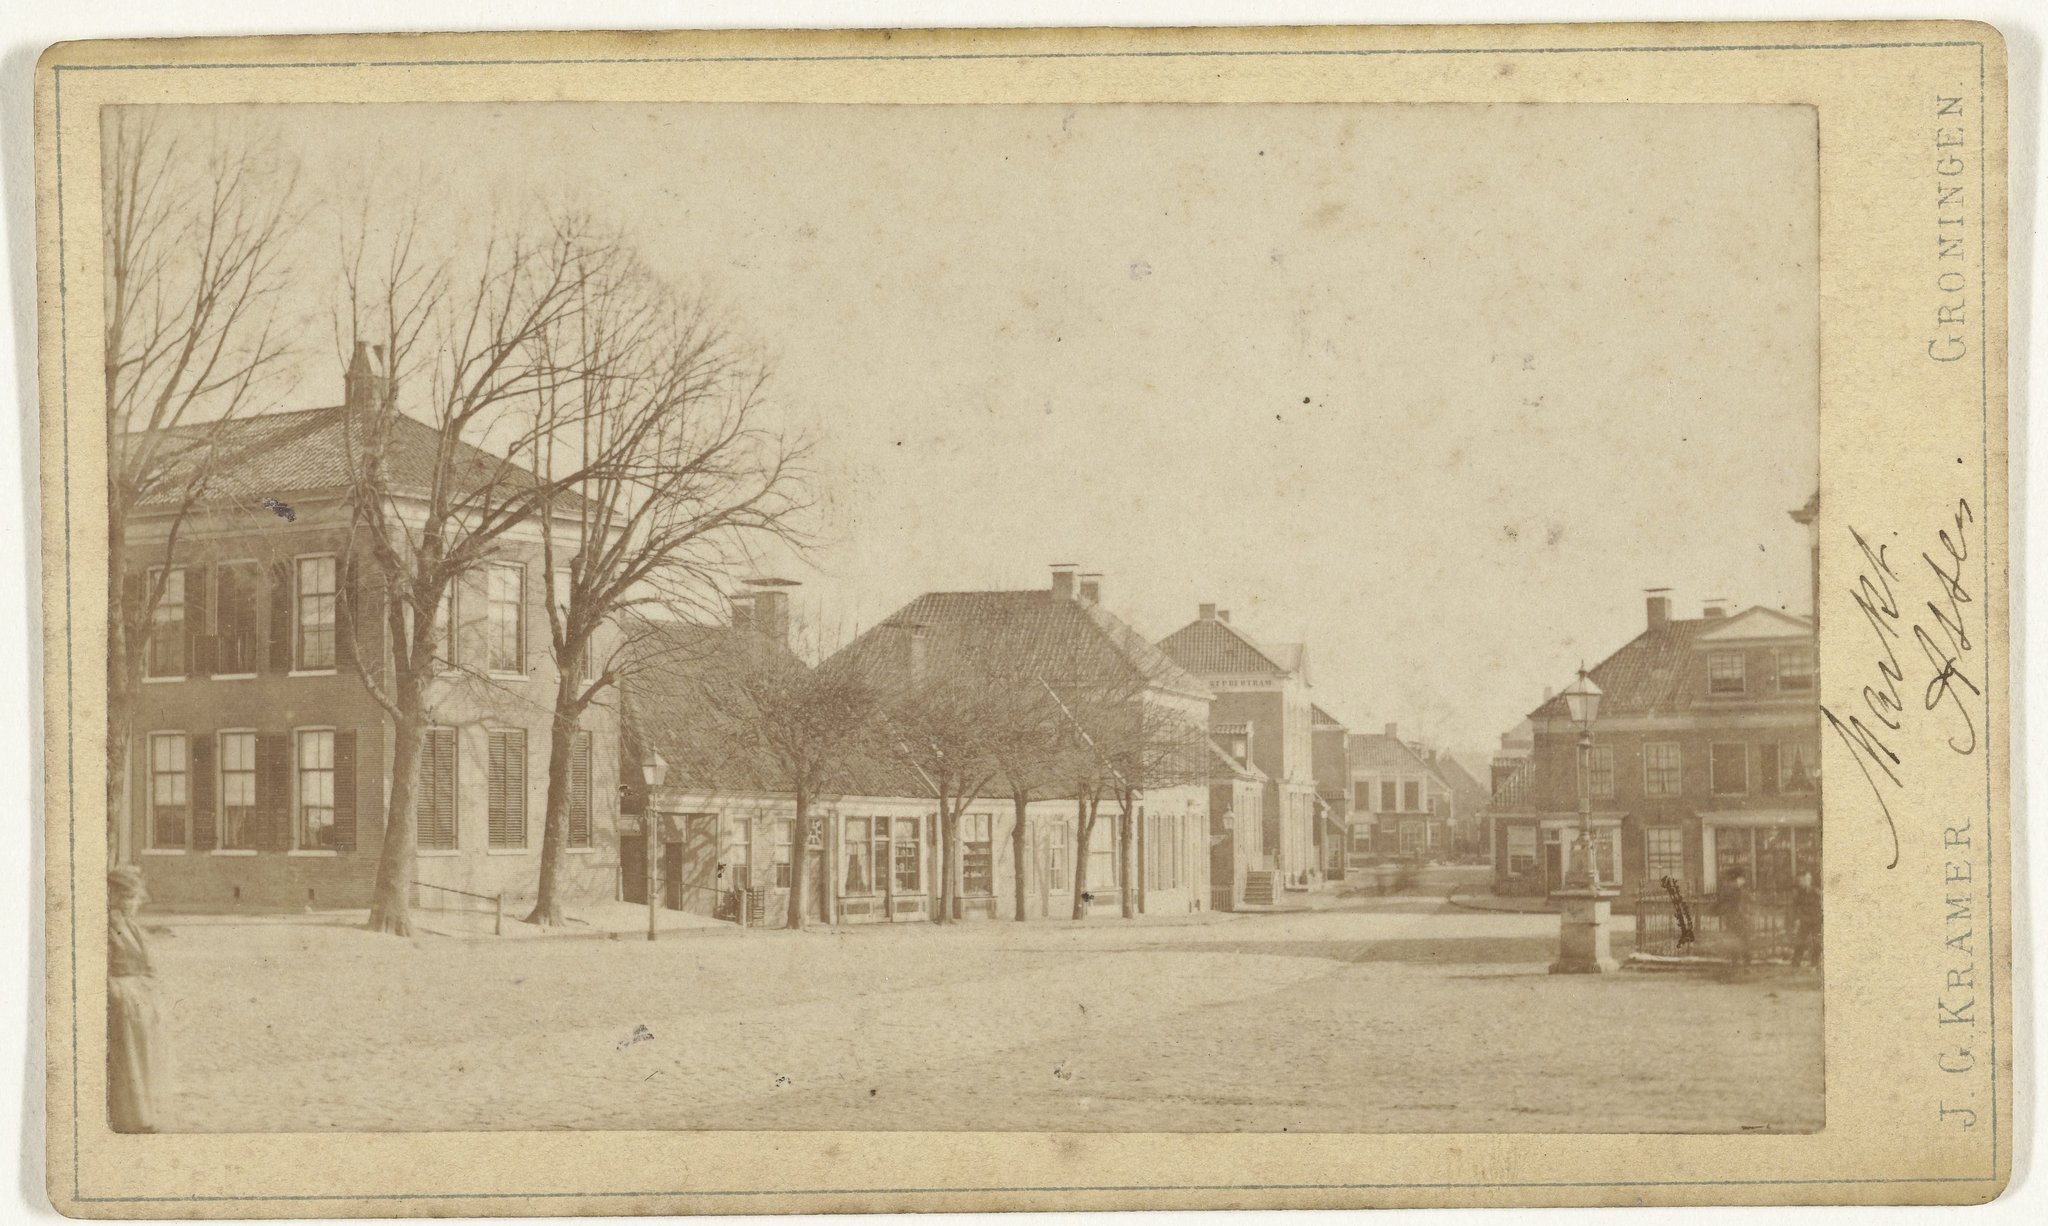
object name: photograph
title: Brink te Assen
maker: johannes gerardus kramer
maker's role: fotograaf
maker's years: 1845-1903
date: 1878-1890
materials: cardboard, paper, photographic support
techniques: albumen print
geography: groningen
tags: square, place, circus, etc.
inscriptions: annotation: ‘Markt Assen’